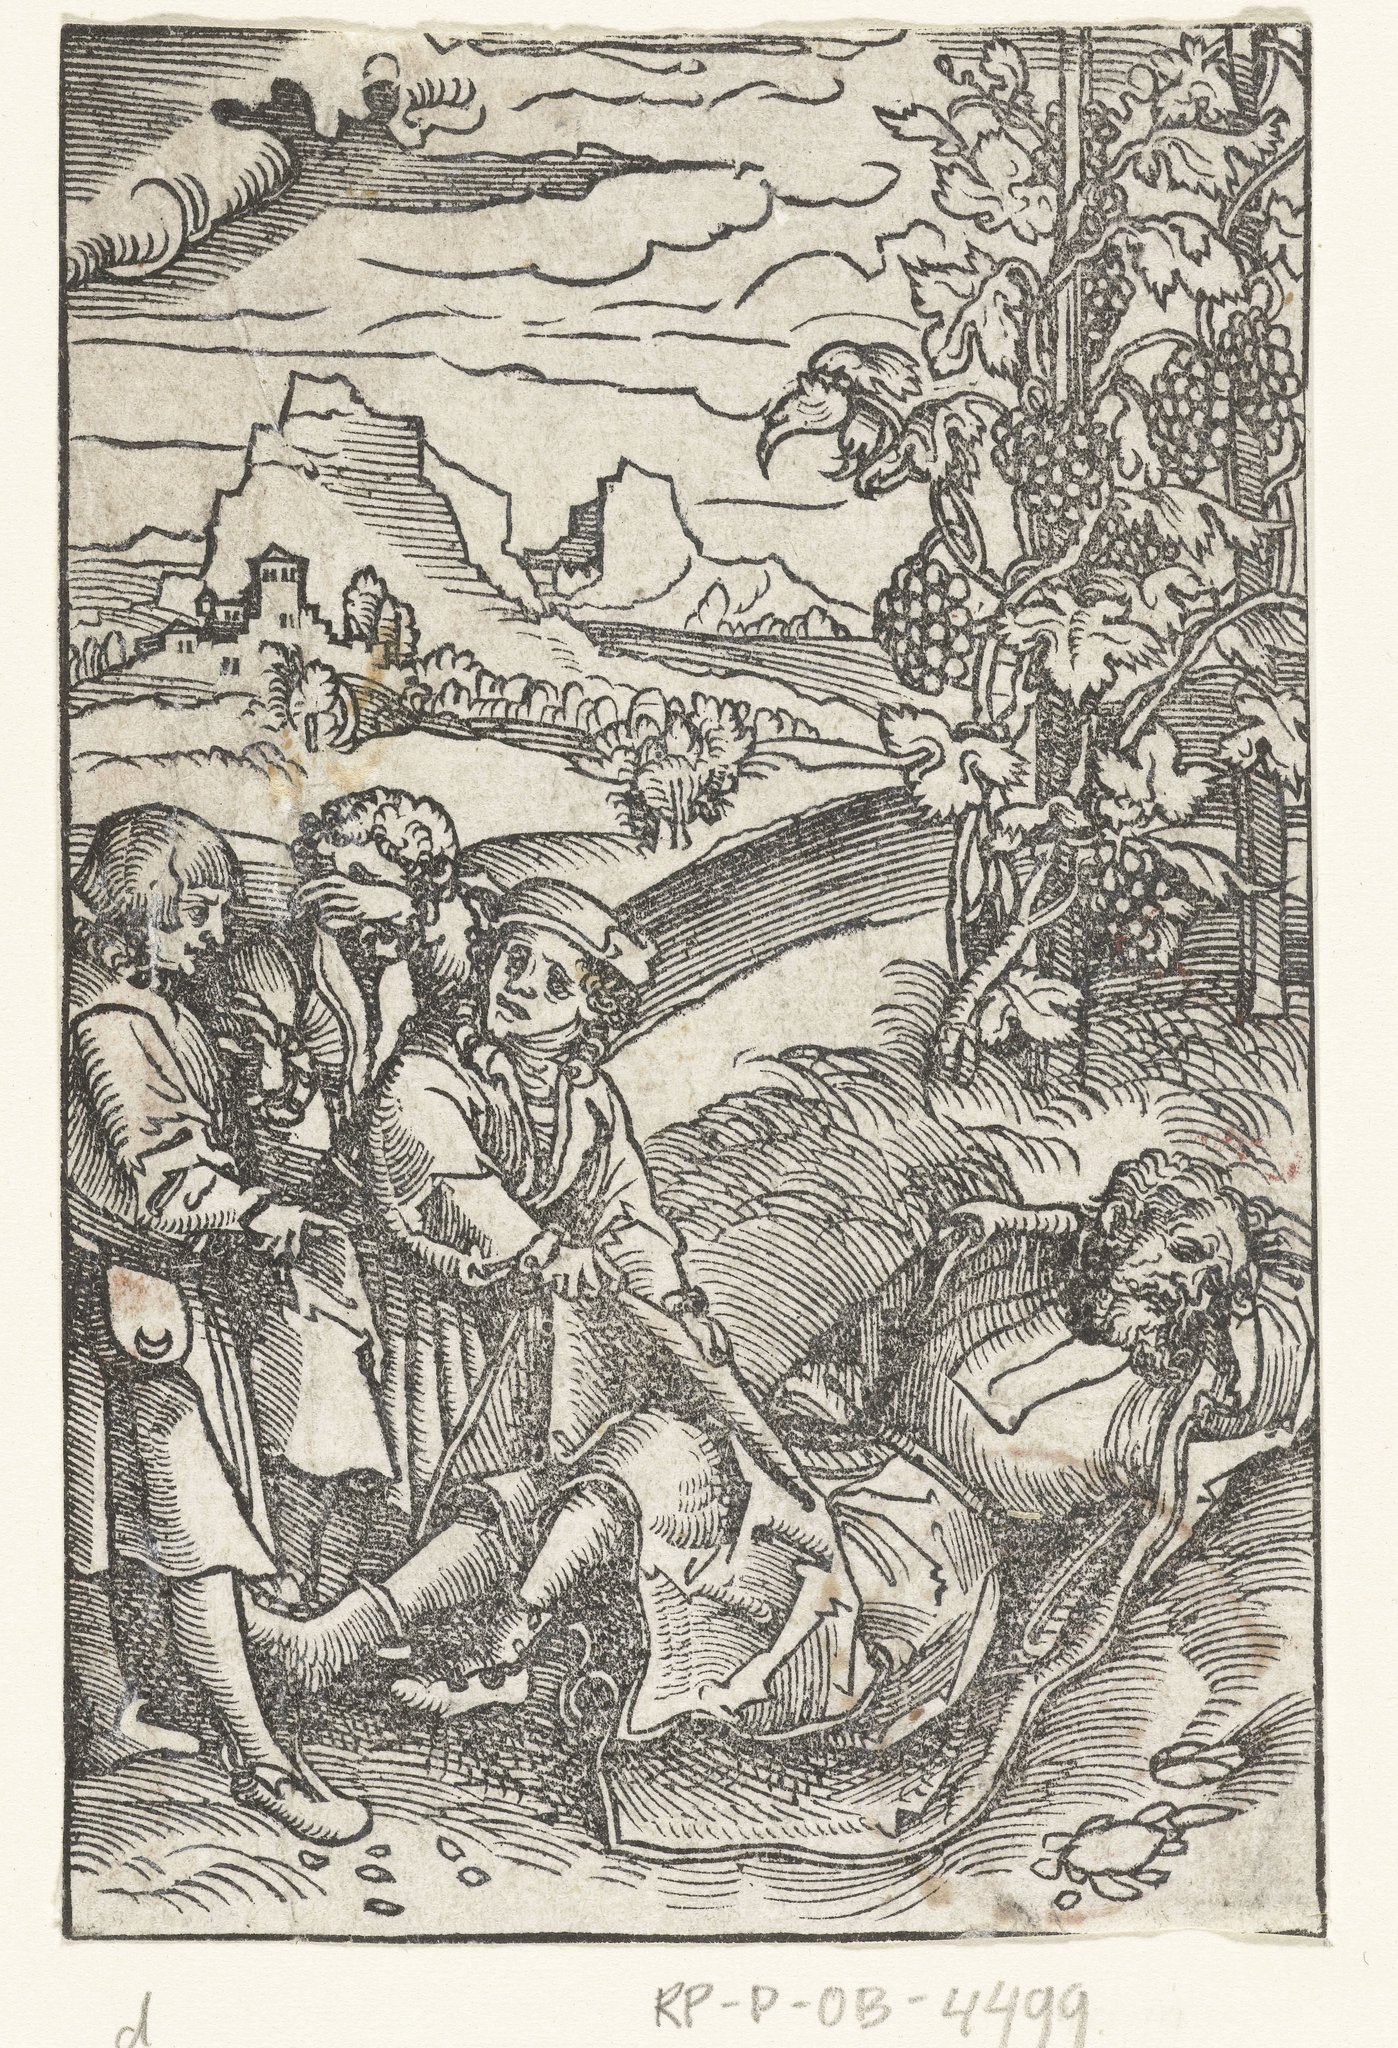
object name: print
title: Tien geboden uitgelegd met bijbelse verhalen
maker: lucas cranach (i)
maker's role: draughtsman, print maker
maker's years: 1472-1553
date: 1528-1554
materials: paper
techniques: woodcut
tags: shem and japheth cover their father noah; ham usually stands nearby deriding him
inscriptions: collector's mark: Lugt 240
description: Houtblokken gebruikt voor: Maarten Luther, Deudsch Catechismus (...), Wittenberg 1529 (eerste druk), uitgever Georg Rhau. Er verschenen diverse heruitgaven, de laatste in 1554, zie Koepplin 1974. Mogelijk zijn de prenten in deze serie proefdrukken voor een van deze uitgaven.